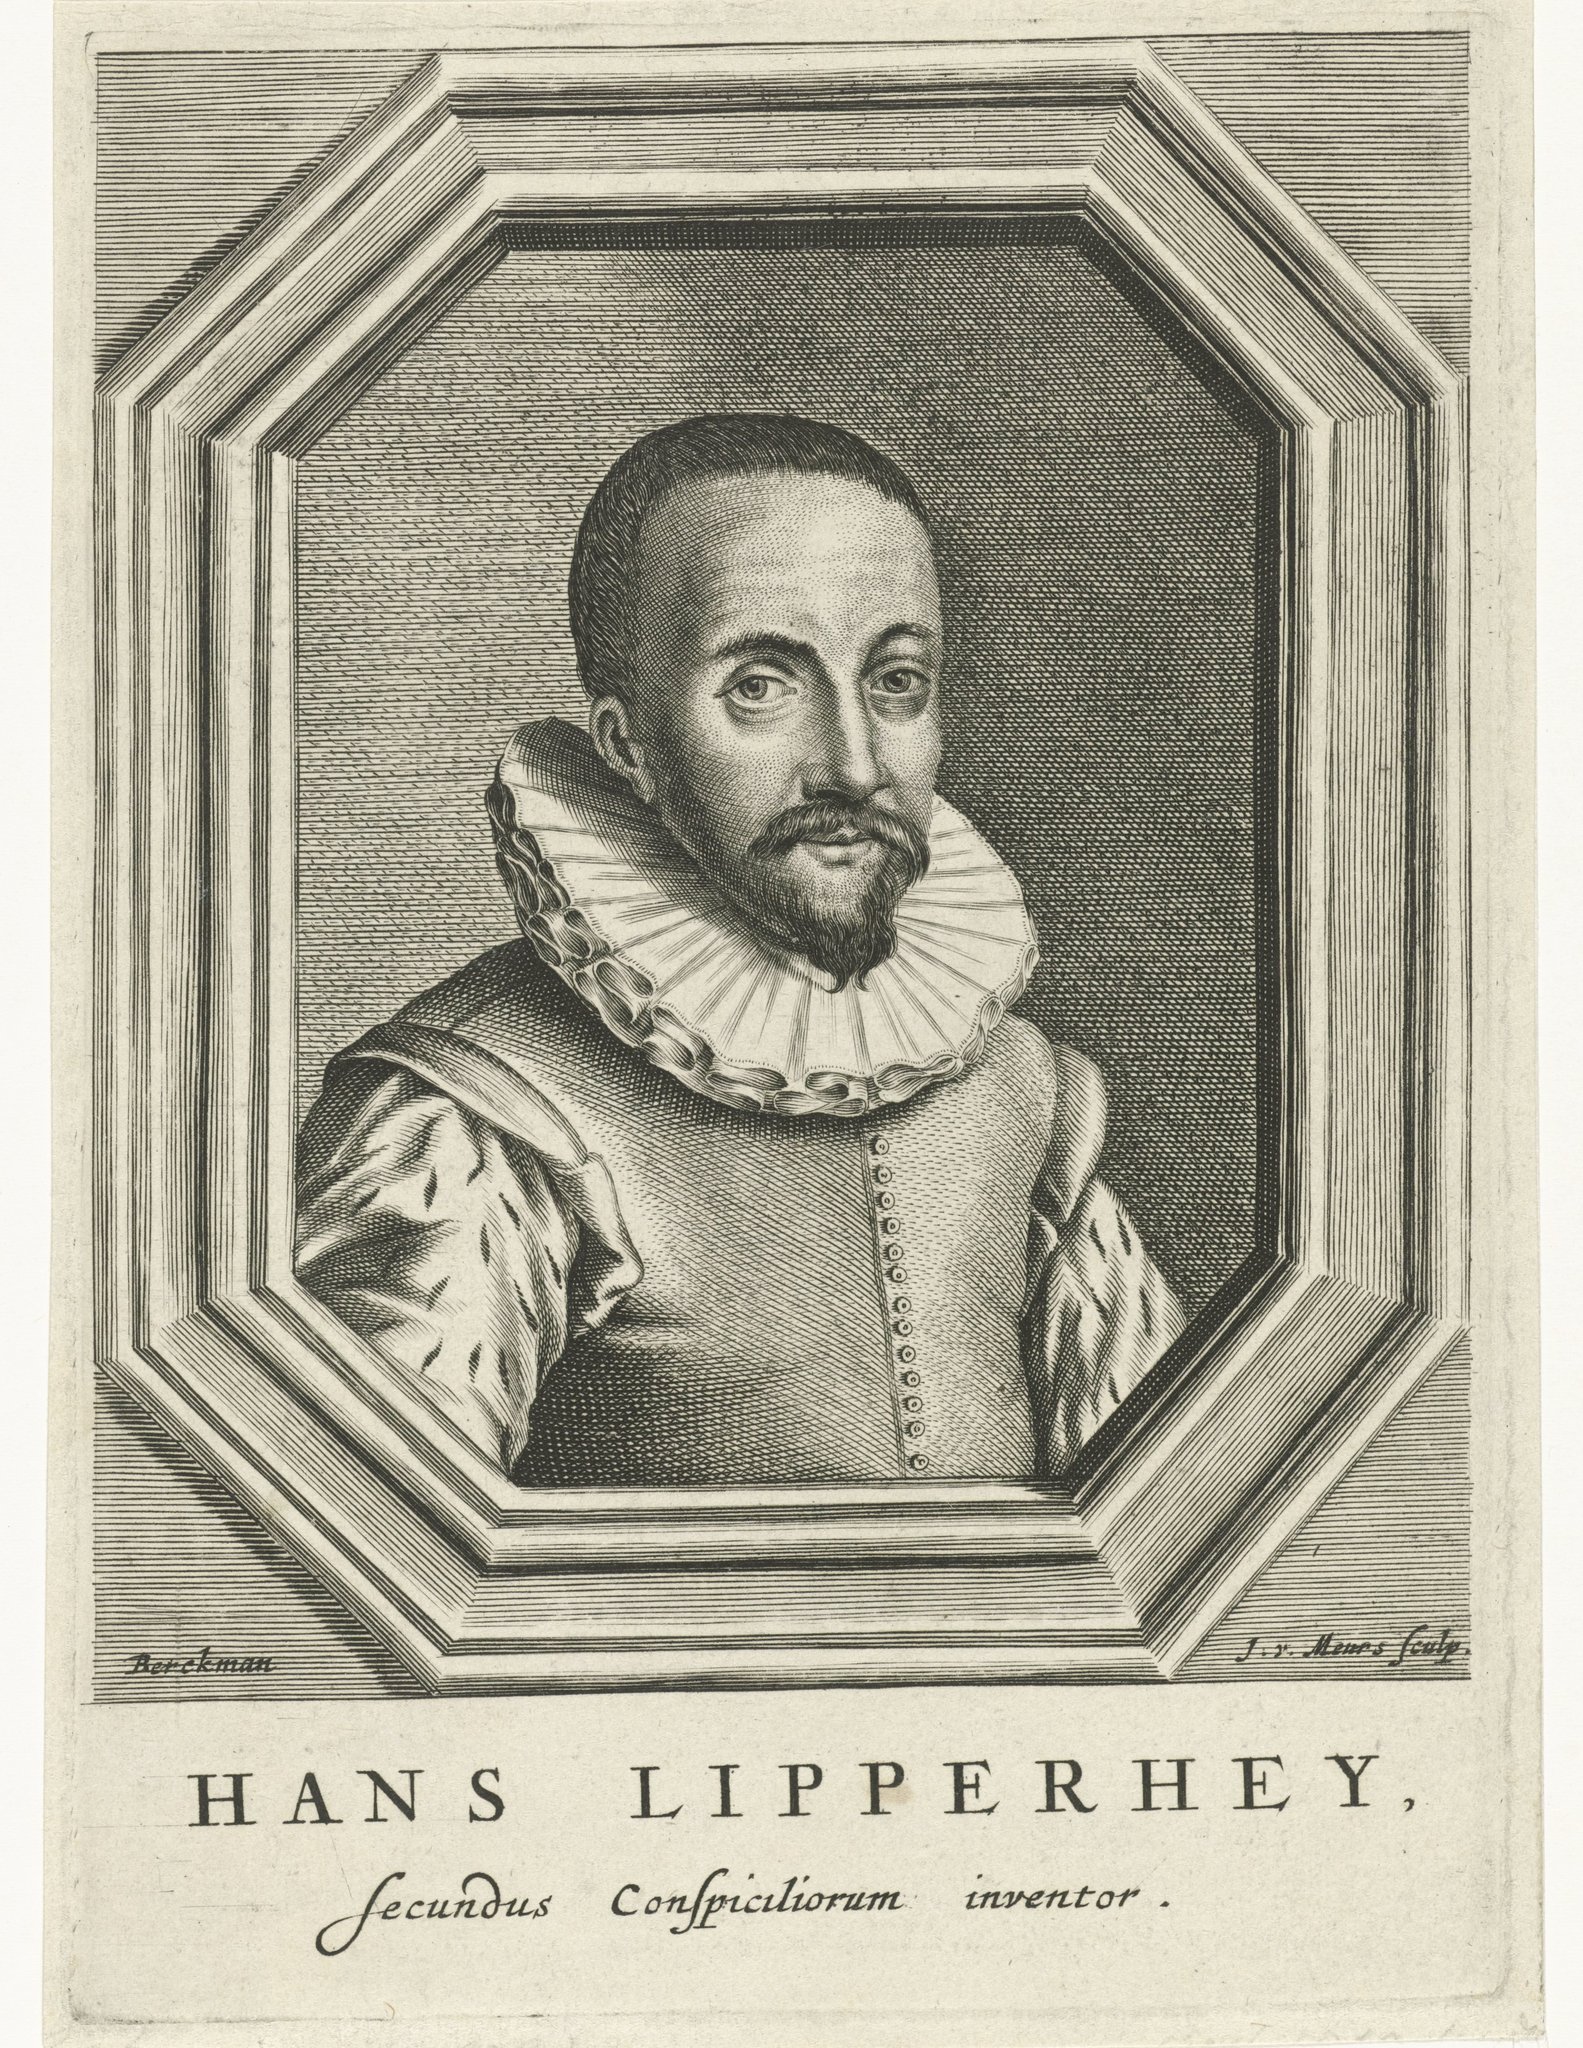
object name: book illustration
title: Portret van Joannes Laprei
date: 1630-1680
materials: paper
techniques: engraving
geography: the hague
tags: middelburg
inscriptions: collector's mark: Lugt 2228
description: Prent uit: Boreel, Petrus. De vero telescopii inventore. Den Haag: Adriaen Vlacq, 1655.